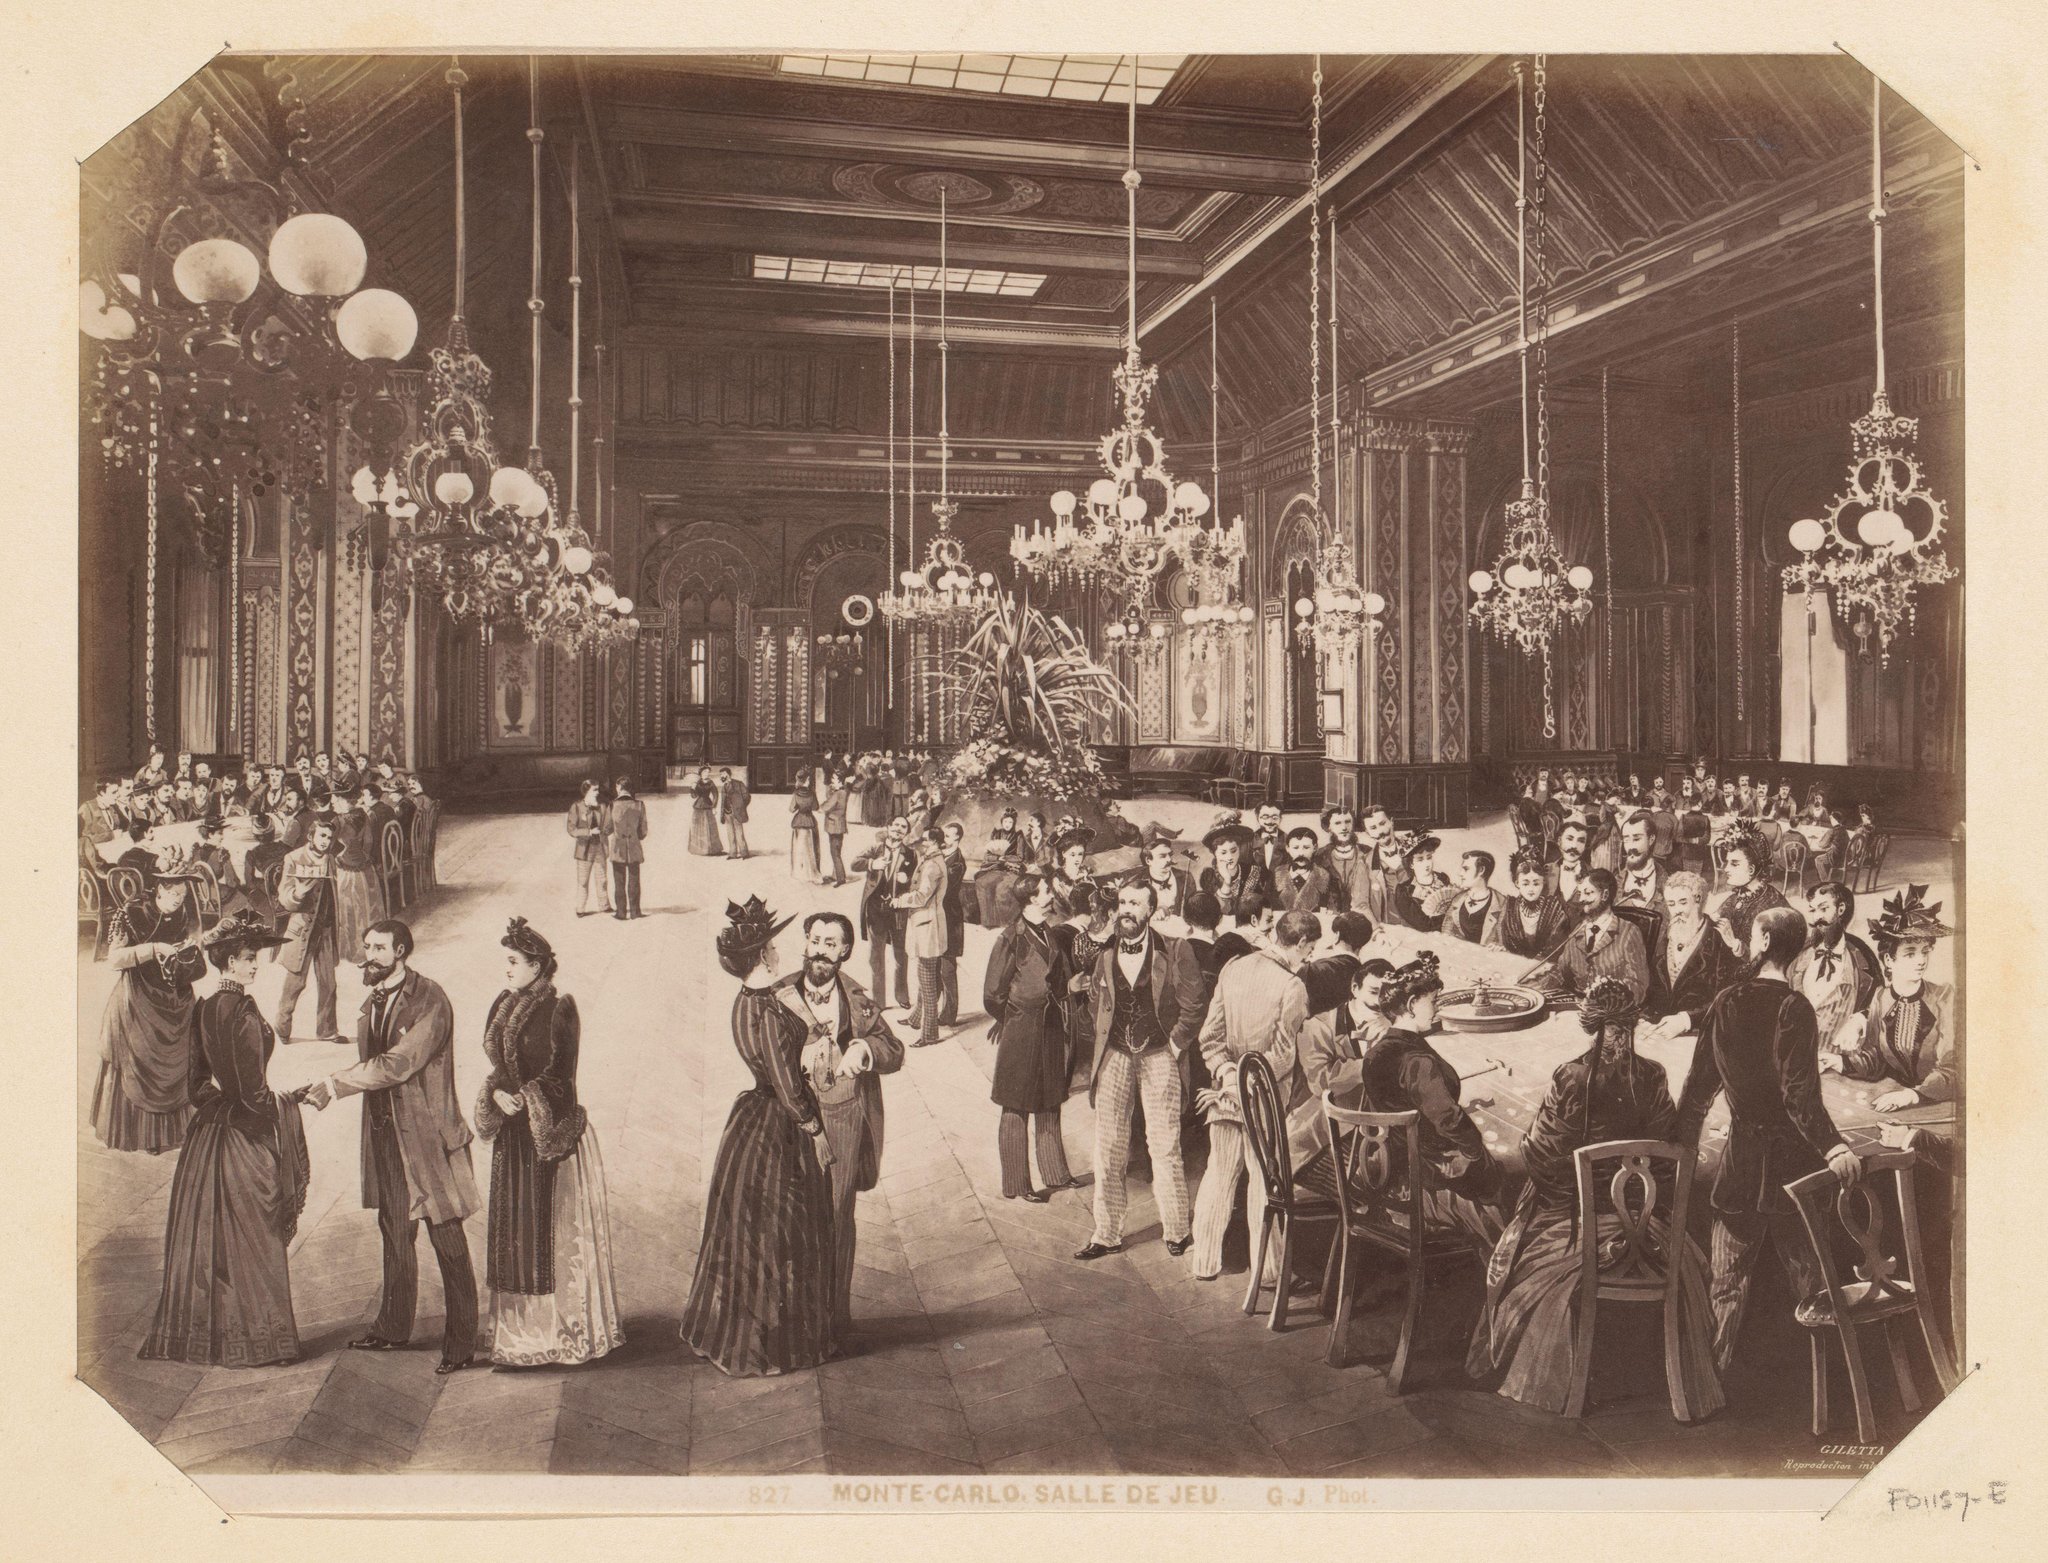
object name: photograph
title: Monte Carlo- Salle de jeu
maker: gj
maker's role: fotograaf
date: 1885-1892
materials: photographic support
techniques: albumen print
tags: painting, drawing and the graphic arts, anonymous historical persons portrayed in a group, in a group-portrait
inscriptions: annotation: ‘Monte Carlo - Speelzaal’